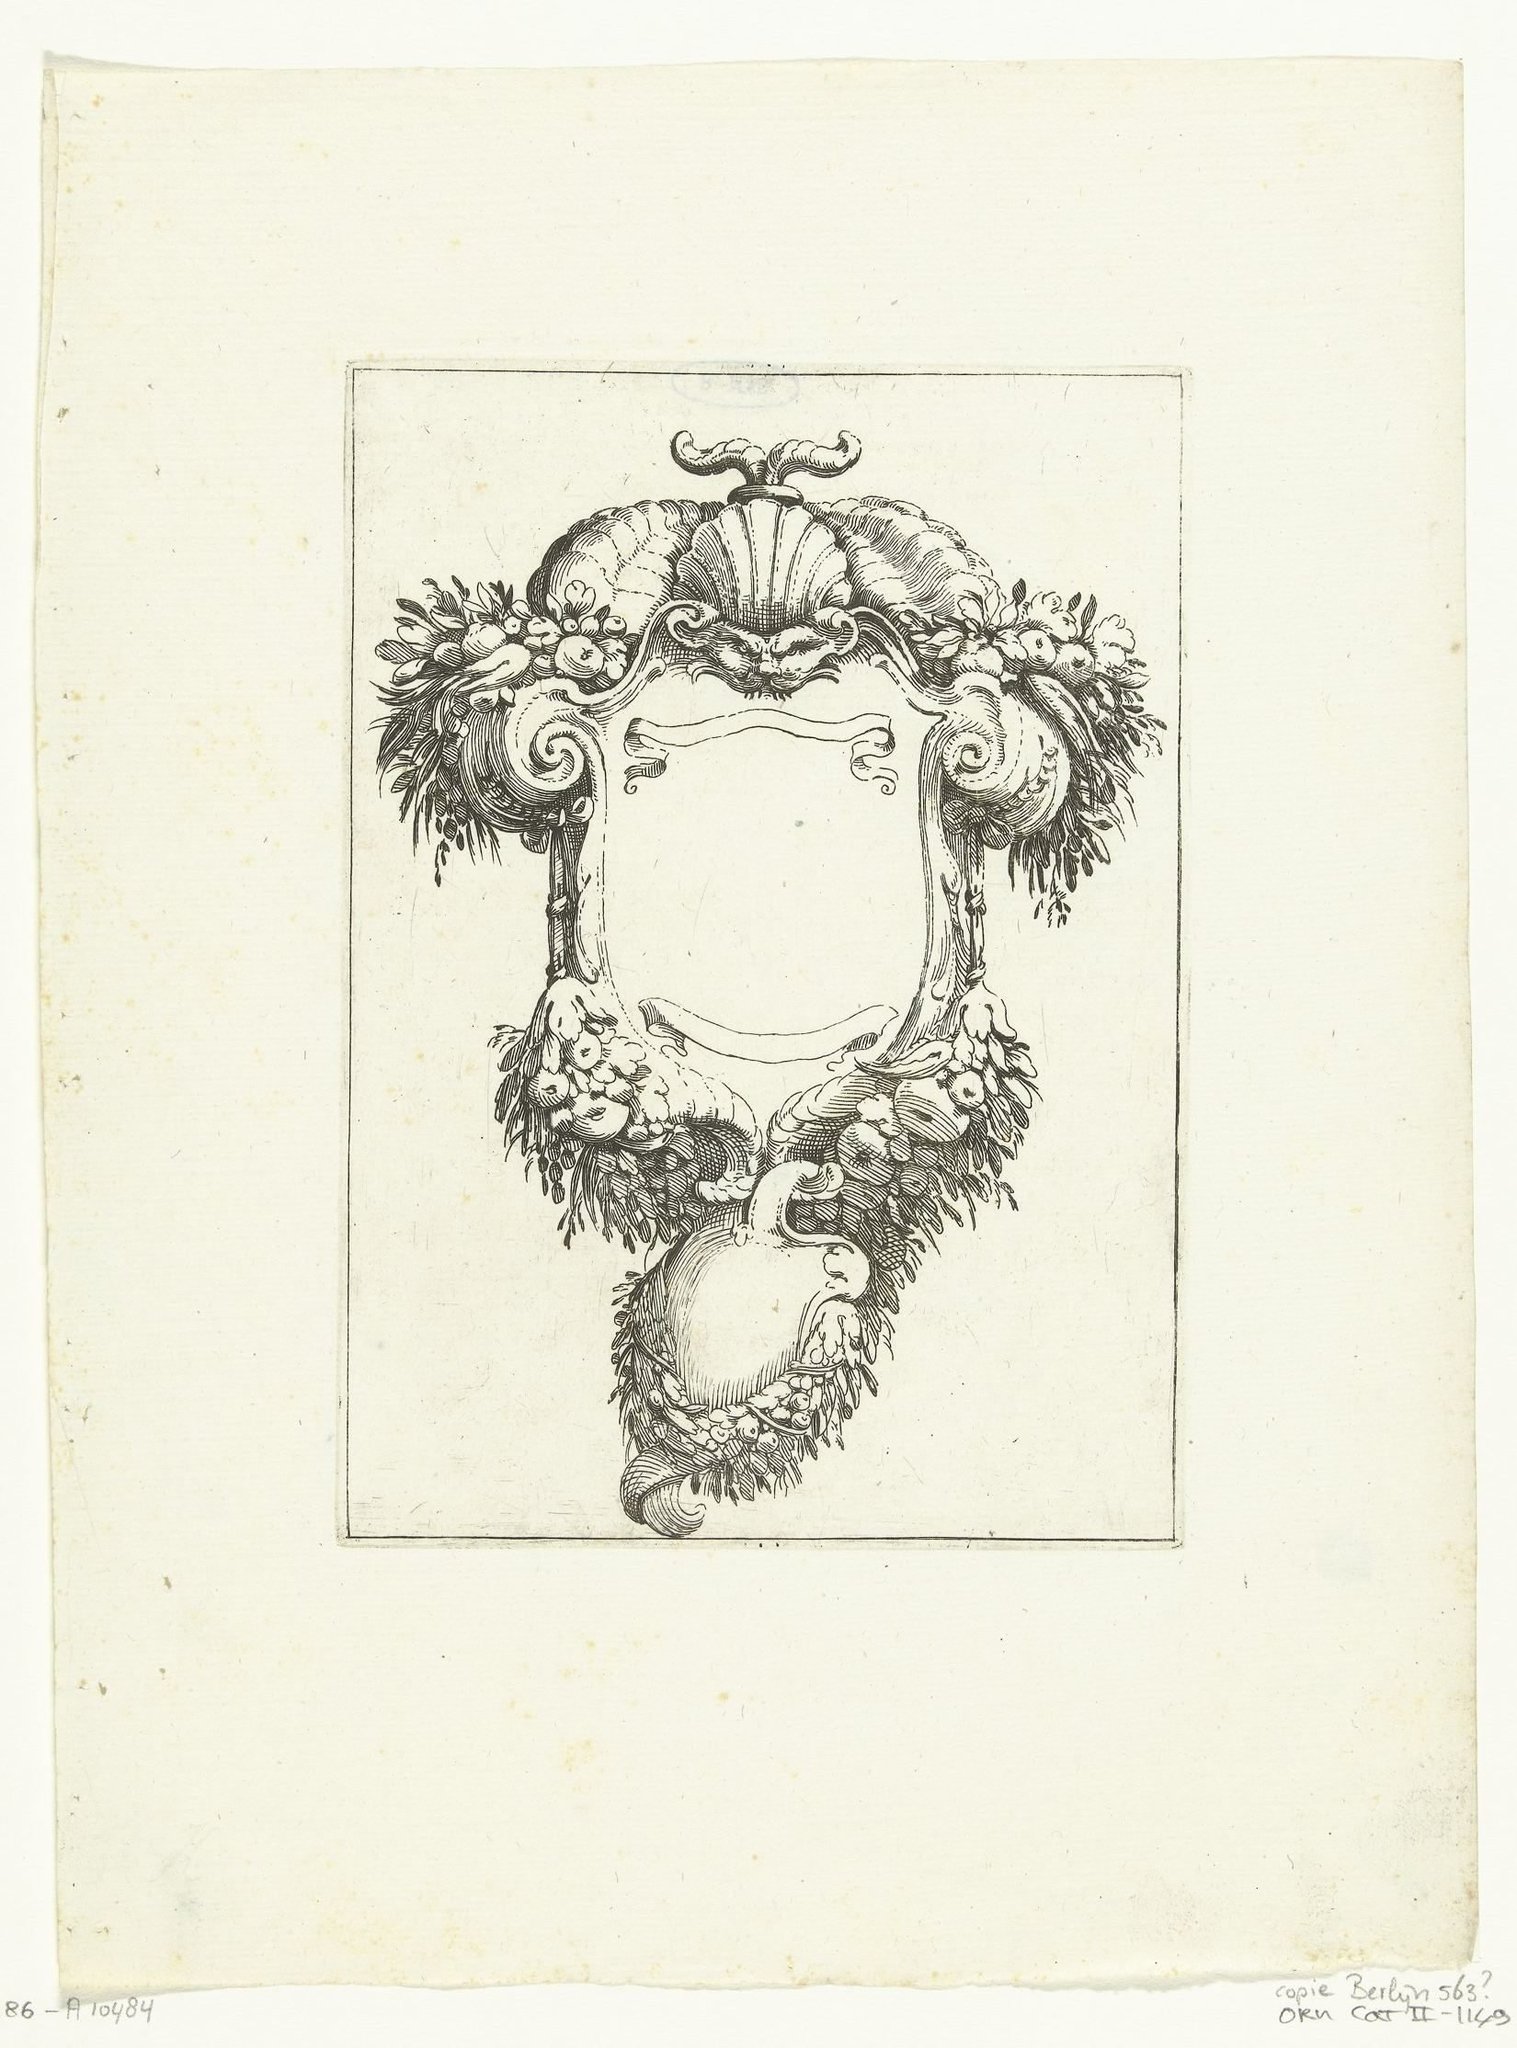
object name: print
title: Cartouche met masker en hoorns des overvloeds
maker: Anonymous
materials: paper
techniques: engraving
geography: italy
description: Cartouche bekroond met een masker met een schelpvormig hoofddeksel tussen twee hoorns des overvloeds. Onderaan hangt een schild. Uit serie van 12 bladen.